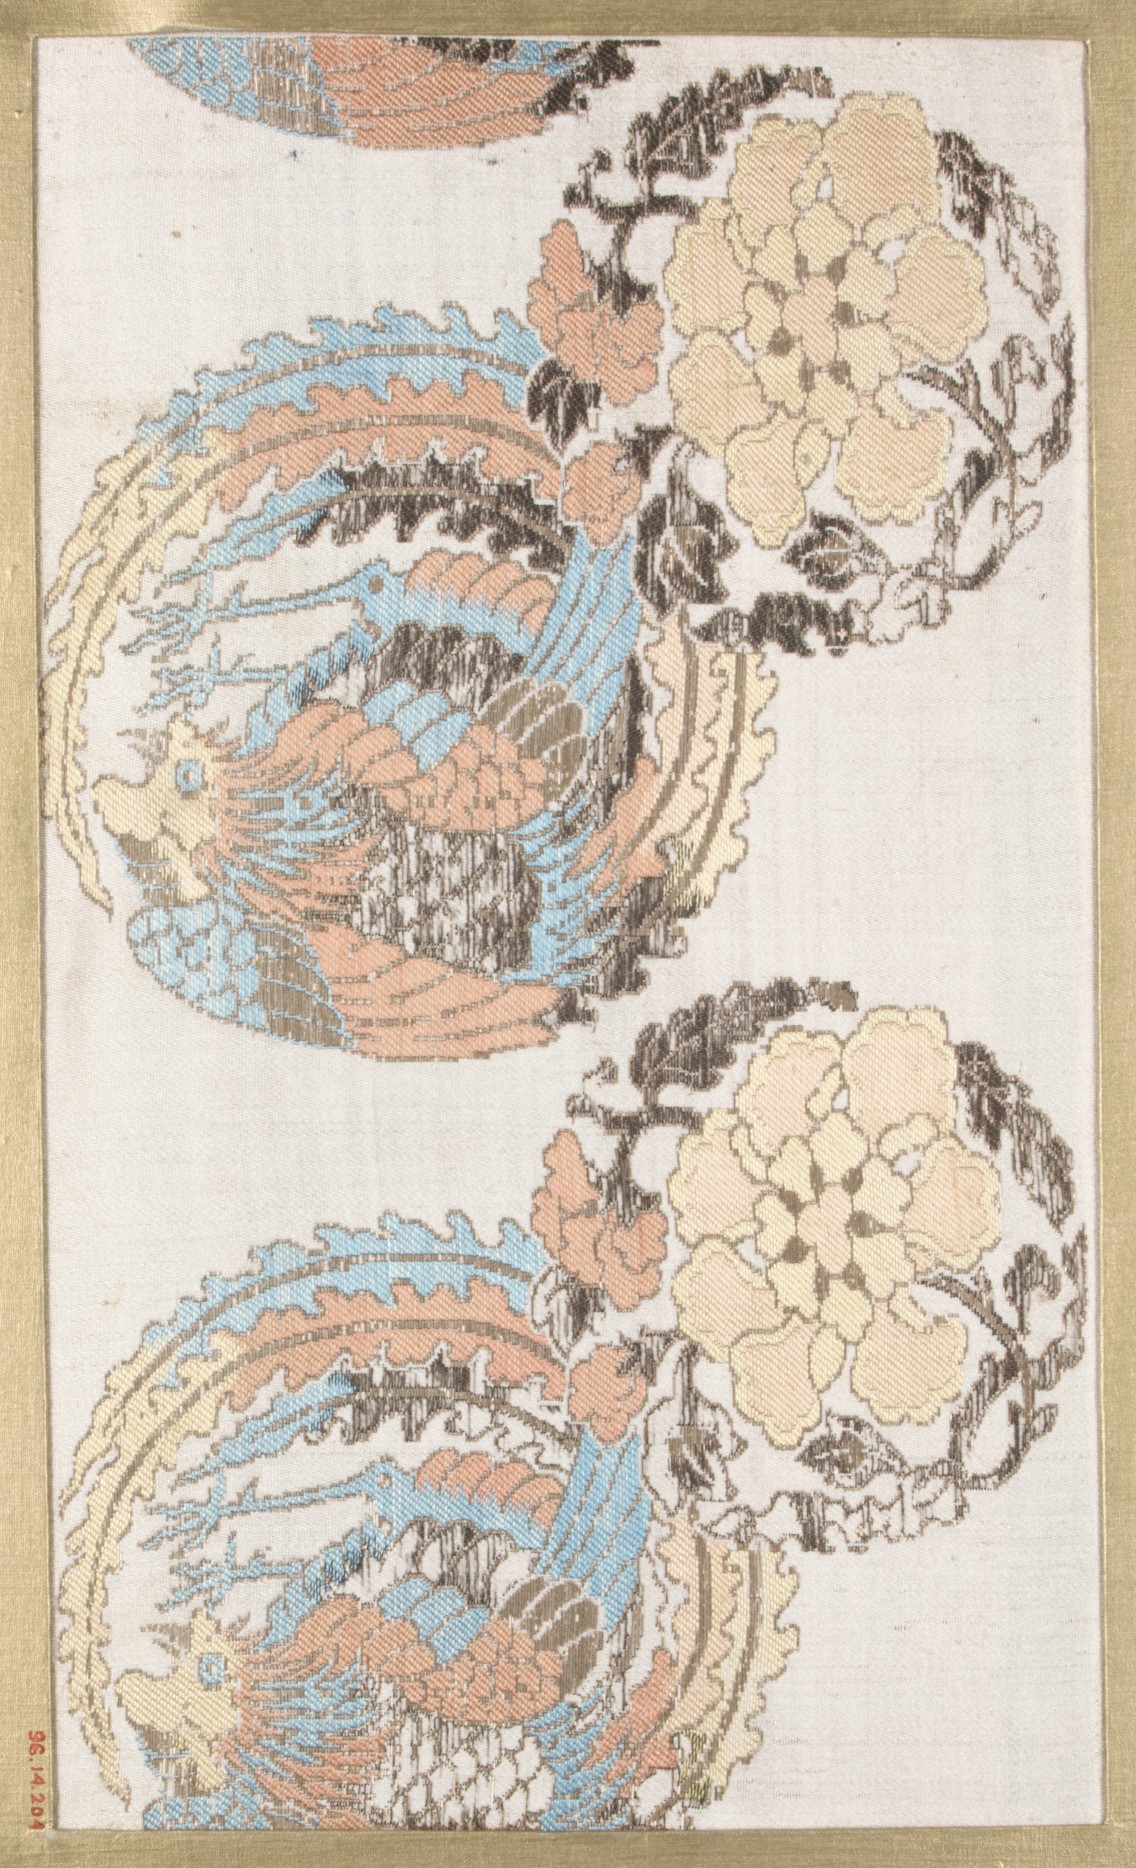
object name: piece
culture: japanese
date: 1701-1900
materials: silk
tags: birds